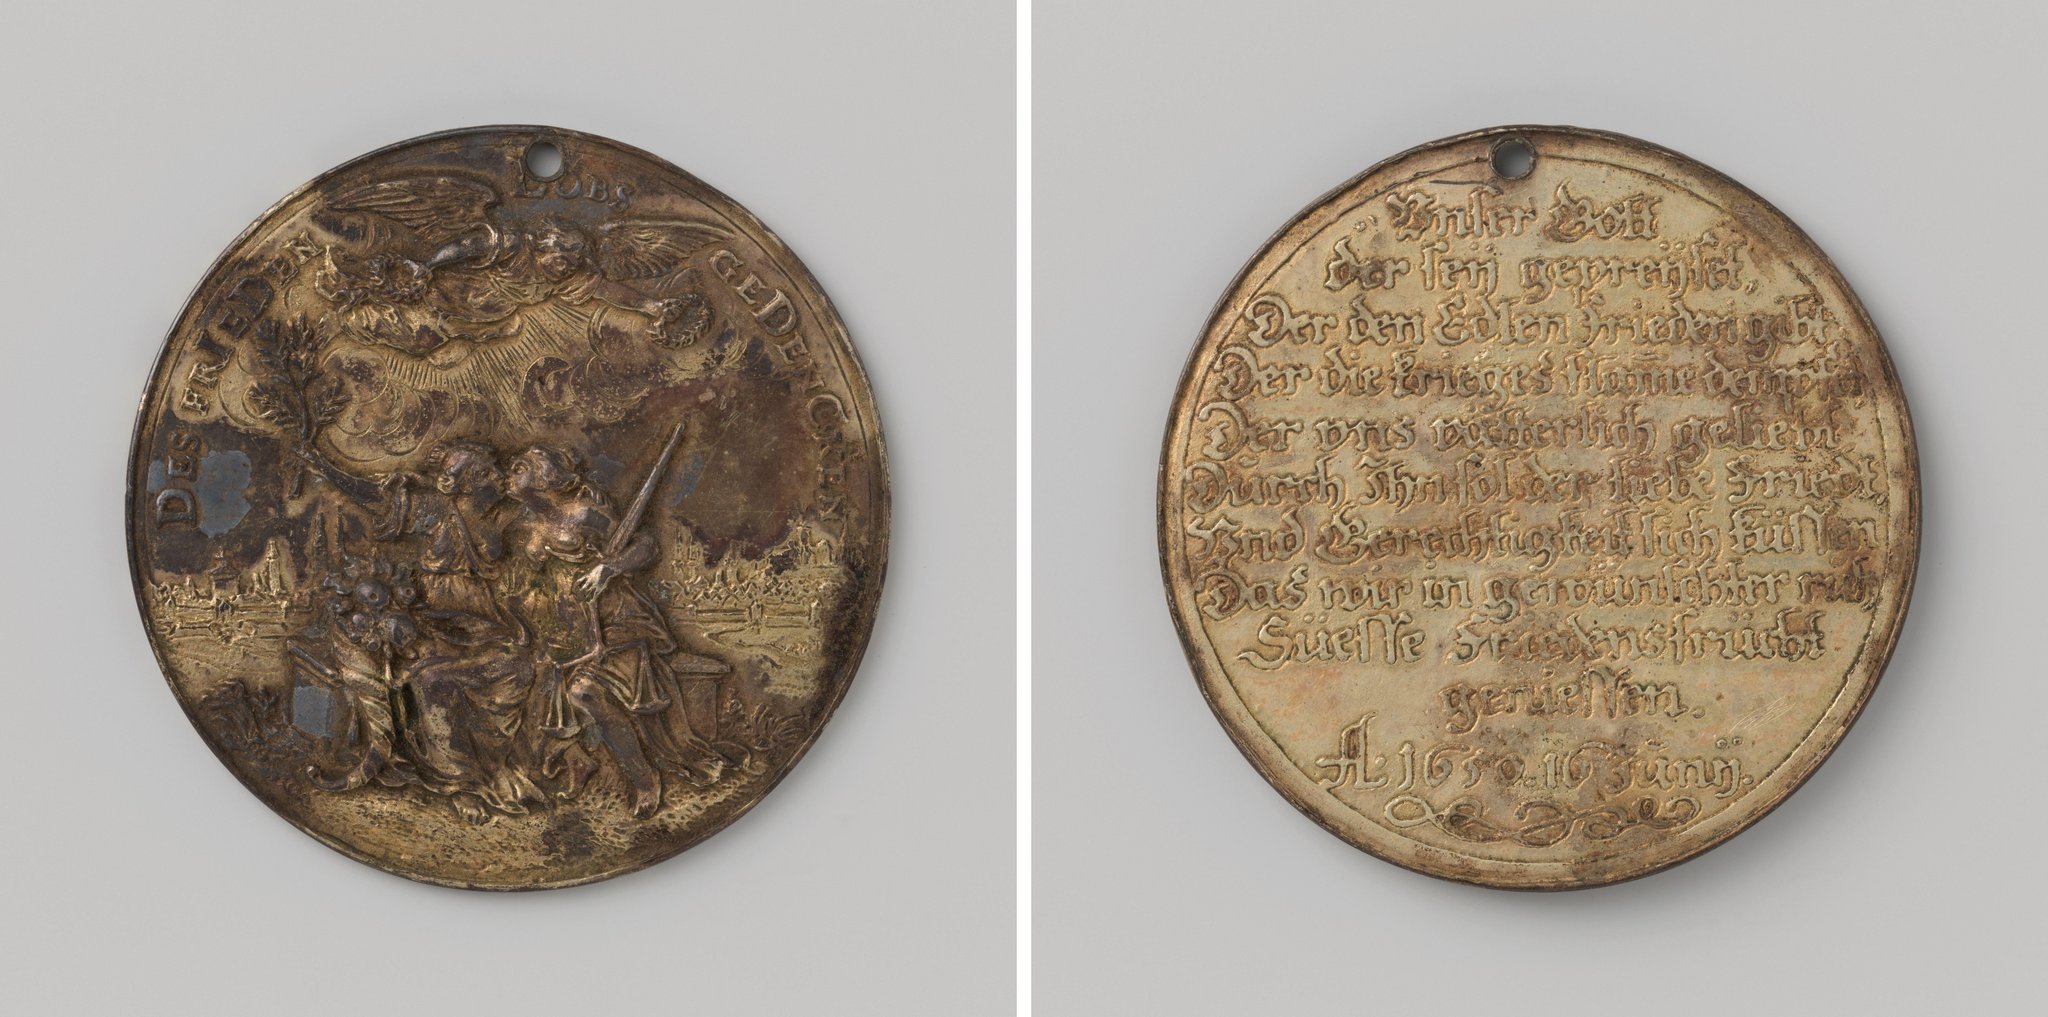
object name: copy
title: PEnning over de Vrede van Munster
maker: Anonymous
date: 1650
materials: silver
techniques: gilding, striking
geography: germany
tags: münster, vrede van münster